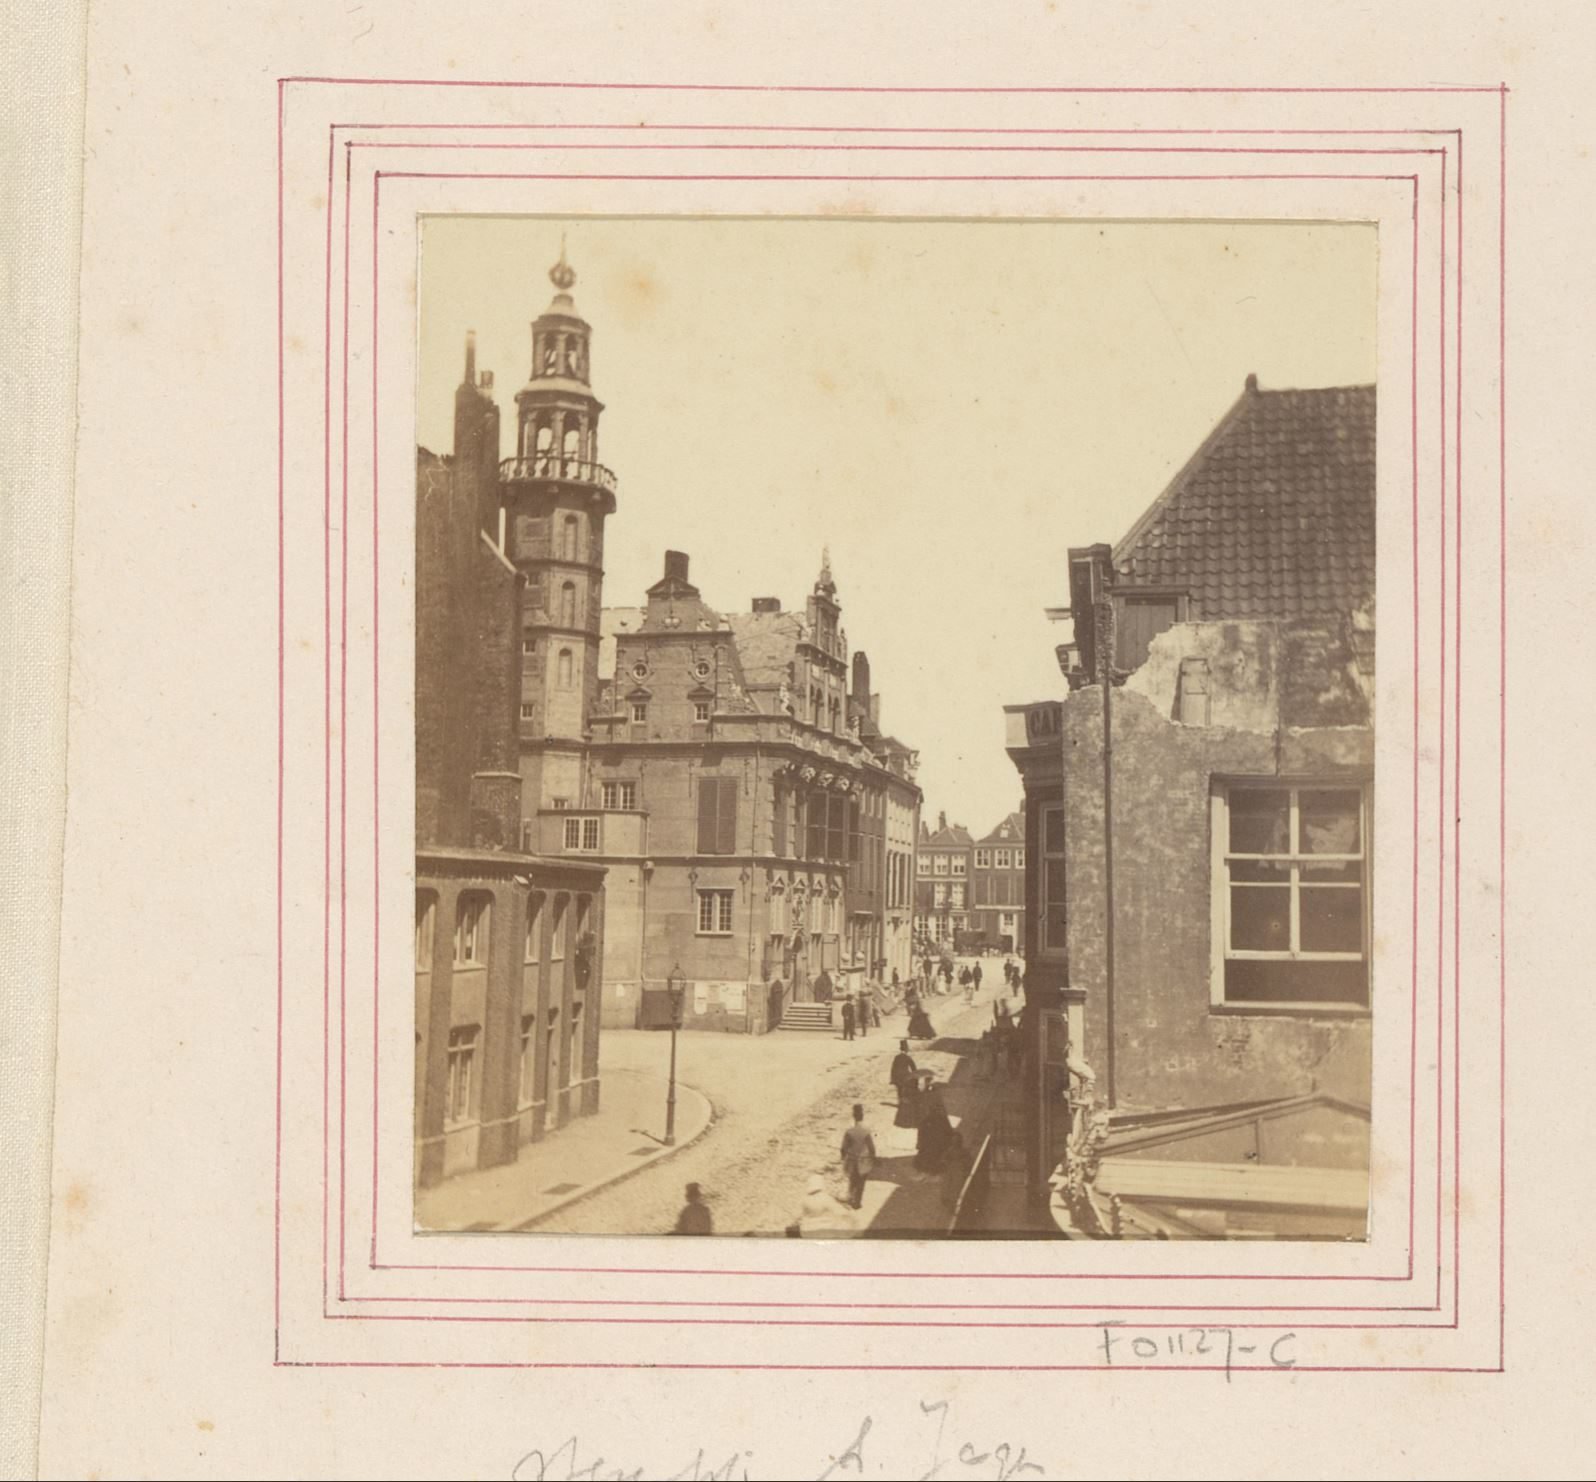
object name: photograph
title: Gezicht op de Groenmarkt met stadhuis in Den Haag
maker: andries jager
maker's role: publisher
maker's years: 1825-1905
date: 1870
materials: photographic support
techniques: albumen print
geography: dagelijkse groenmarkt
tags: townhall, street (+ city(-scape) with figures, staffage)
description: Onderdeel van Album met foto's en litho's van bezienswaardigheden in Noord- en Zuid-Hollandse steden, schilderijen en klederdrachten.